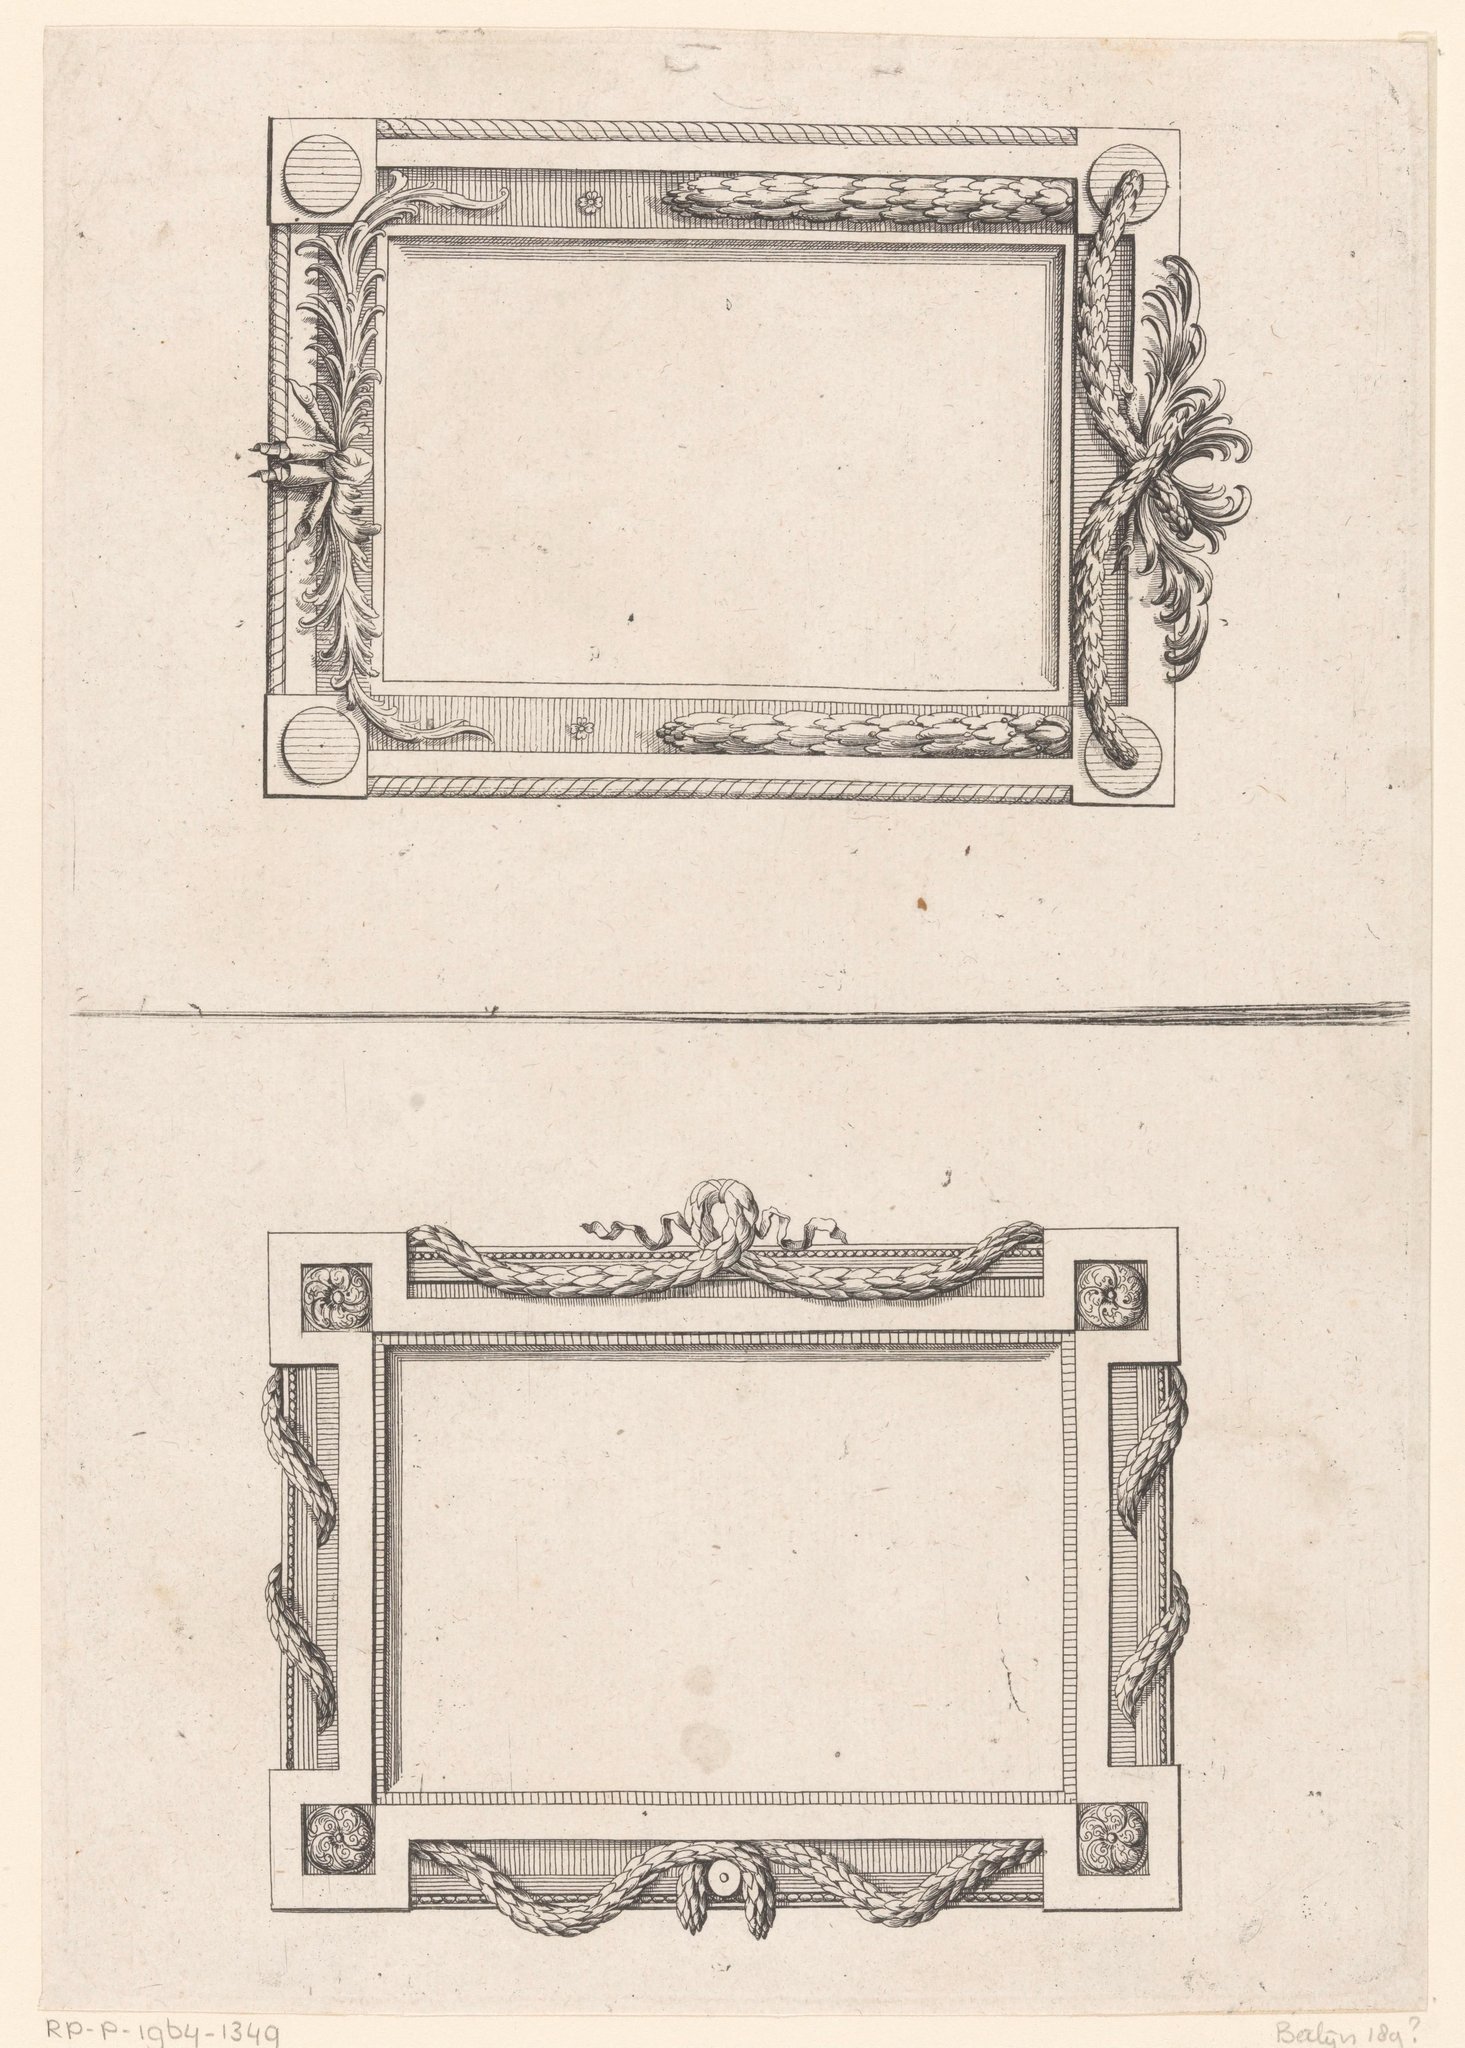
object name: print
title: Omlijstingen met laurierguirlandes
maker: johann thomas hauer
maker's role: print maker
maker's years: 1748-1820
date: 1758-1820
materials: paper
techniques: engraving, etching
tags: ornaments ~ art (+ framing decorations)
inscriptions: collector's mark: Lugt 2228, collector's mark: Lugt 2760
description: Twee rechthoekige omlijstingen met laurierguirlandes.